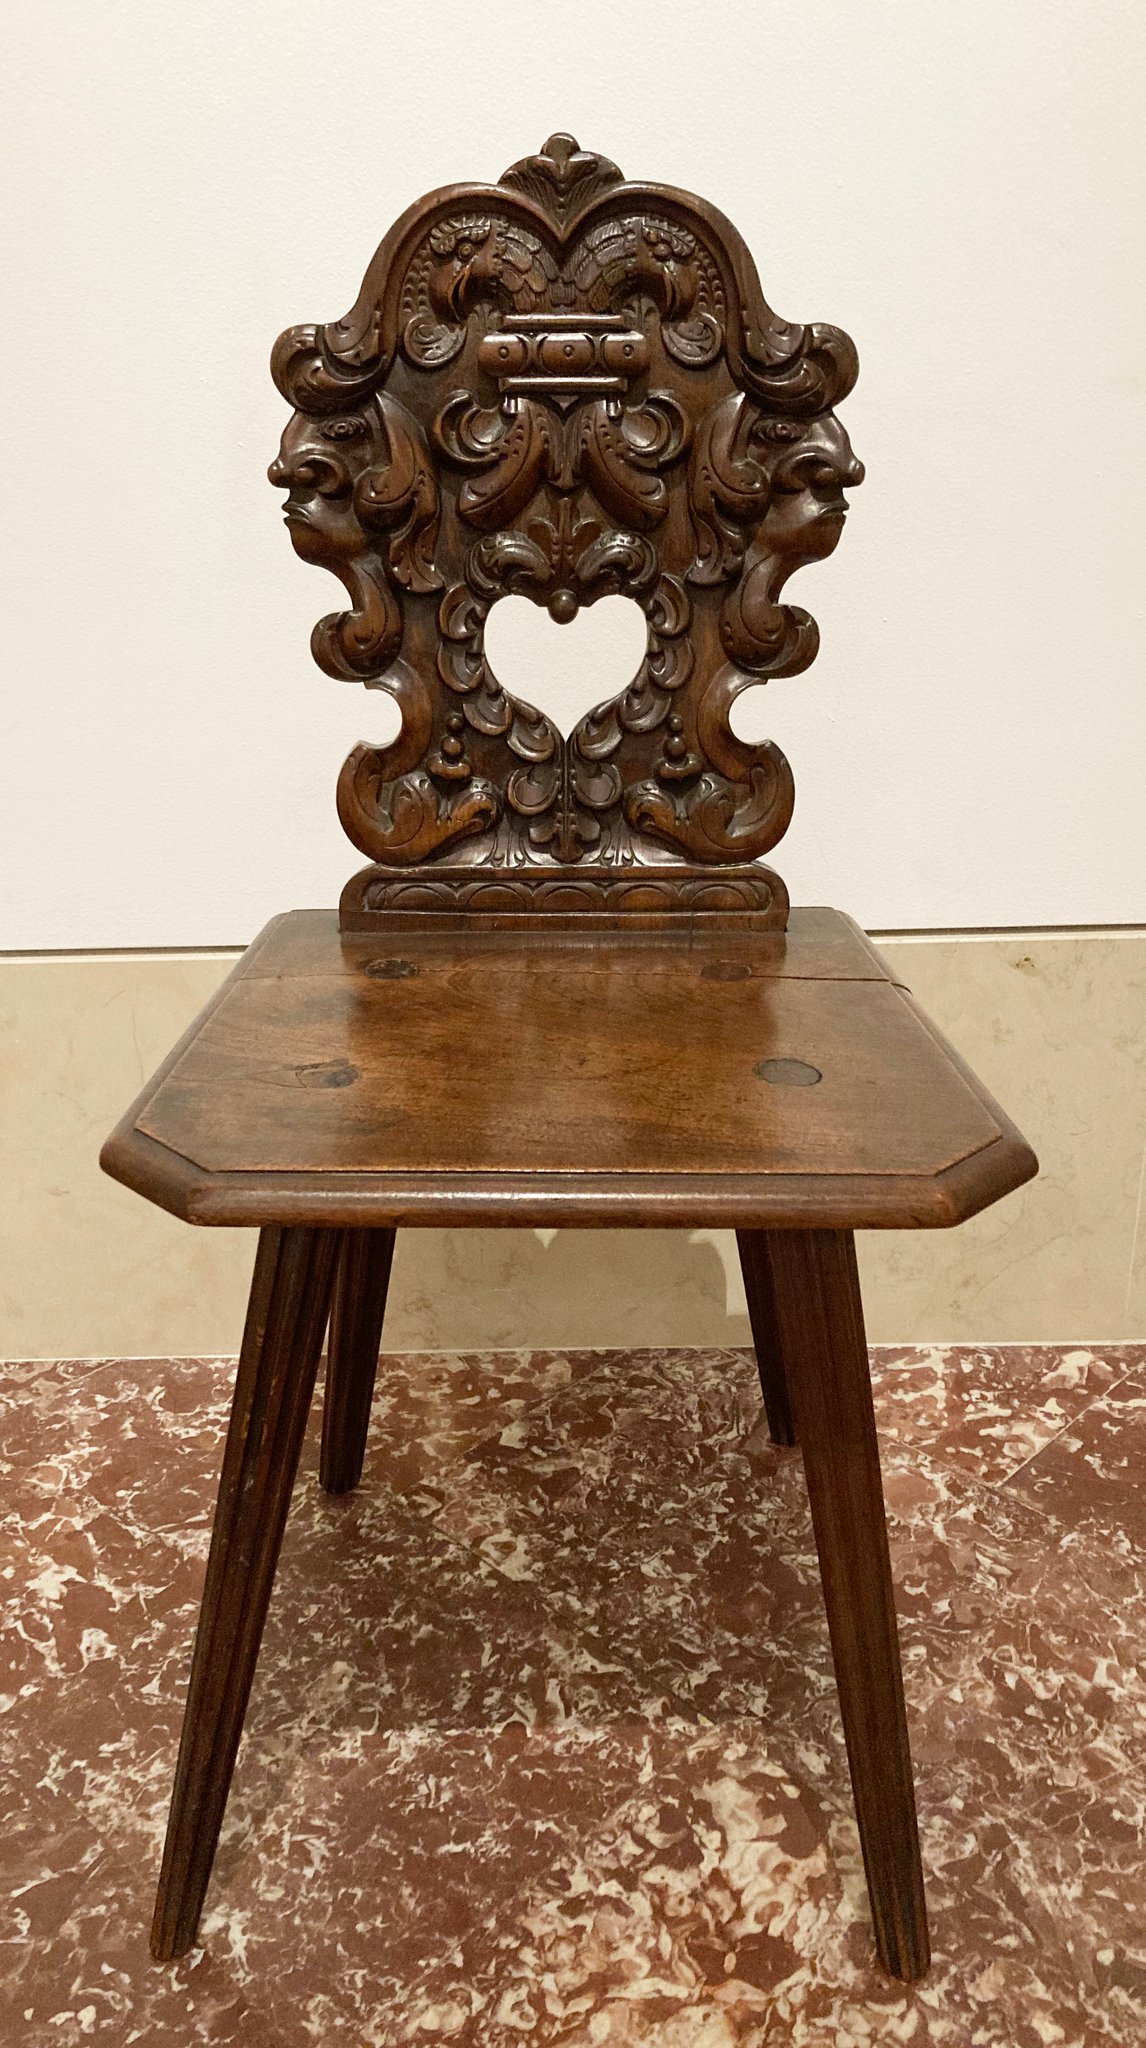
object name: chair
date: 1667-1700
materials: wood